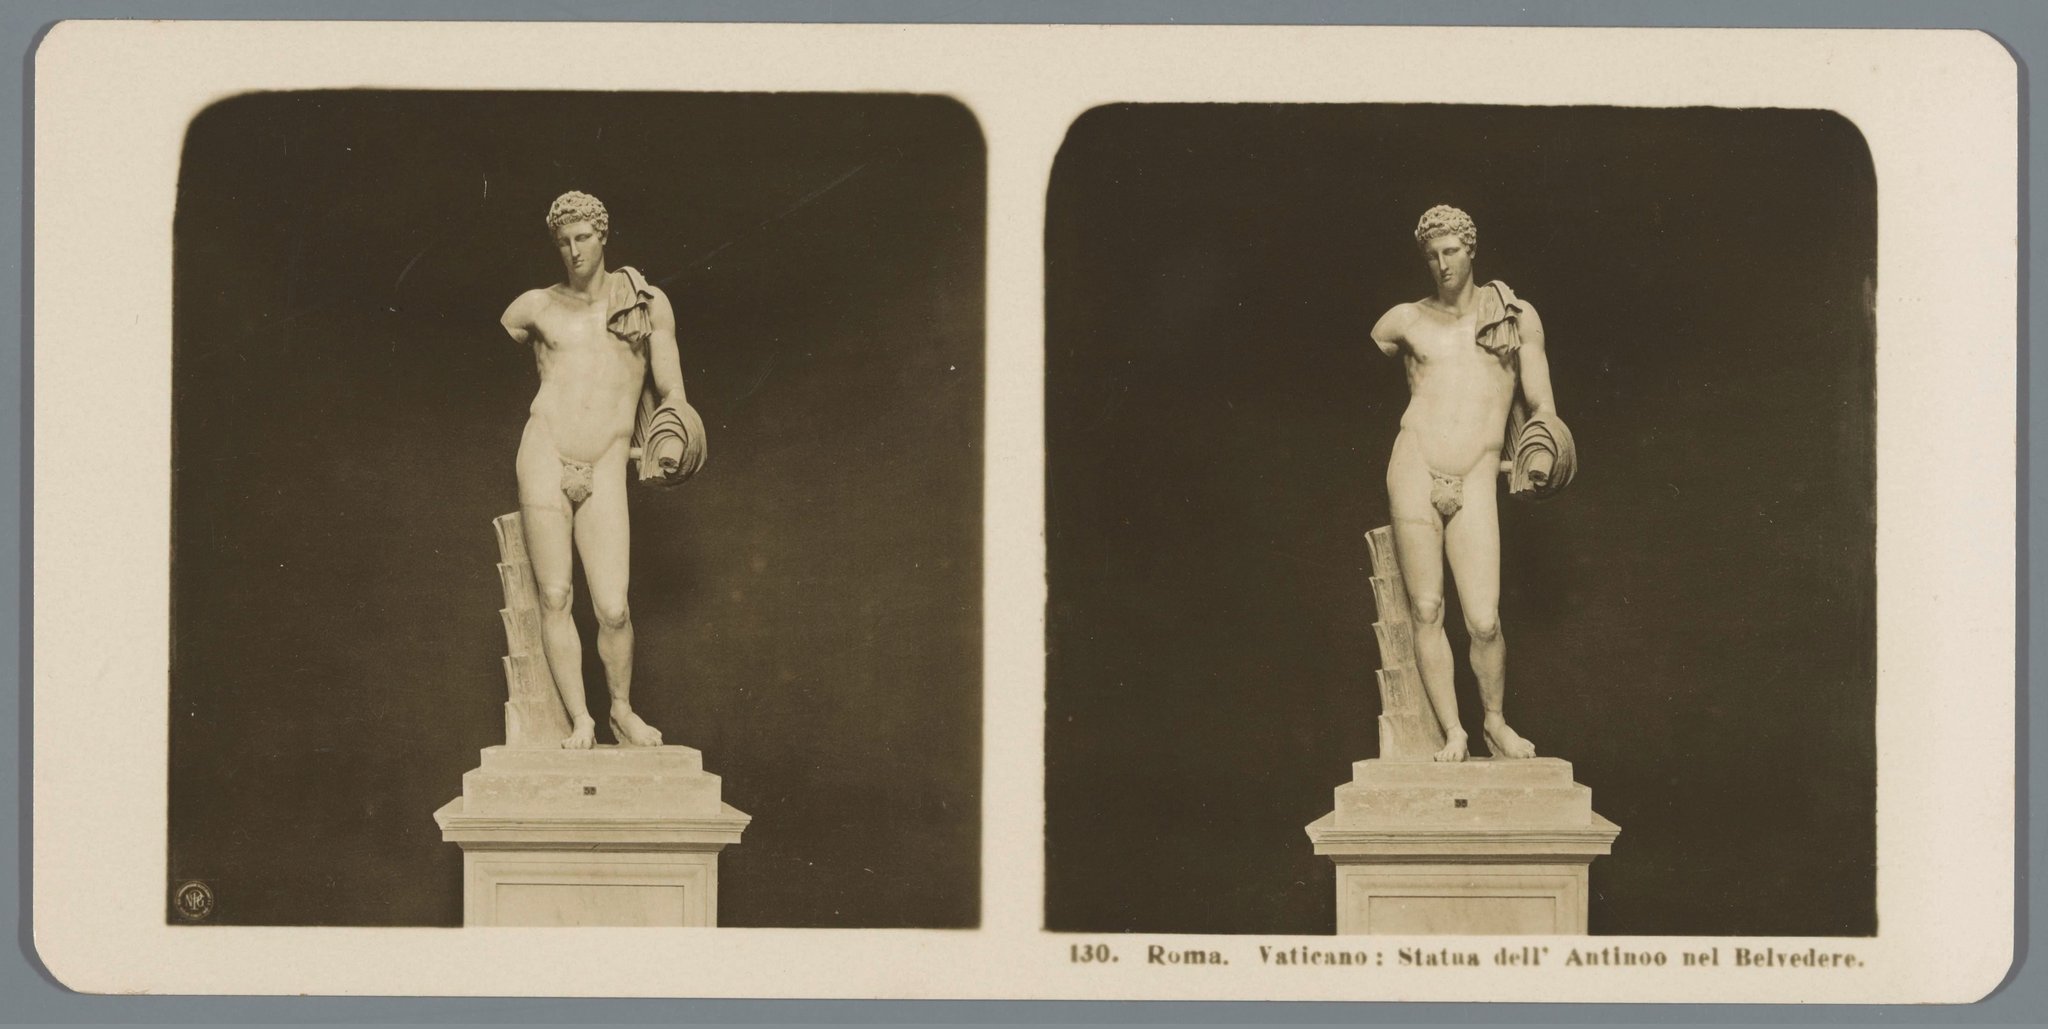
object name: stereograph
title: Standbeeld van Hermes van Belvedere in de Vaticaanse Musea te Vaticaanstad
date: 1900-1910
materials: cardboard, photographic support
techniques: gelatin silver print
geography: vatican museums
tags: (story of) mercury (hermes), sculpture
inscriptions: inscription: ‘NPG’, number: ‘130.’